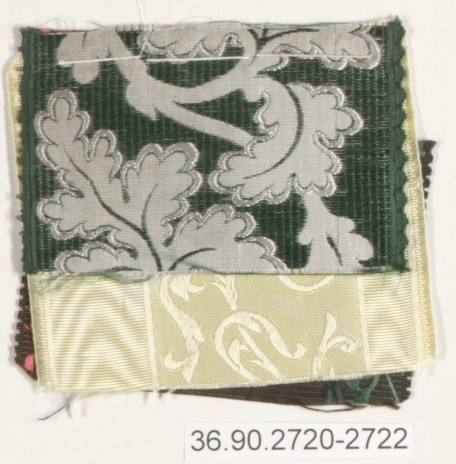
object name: ribbon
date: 1801-1900